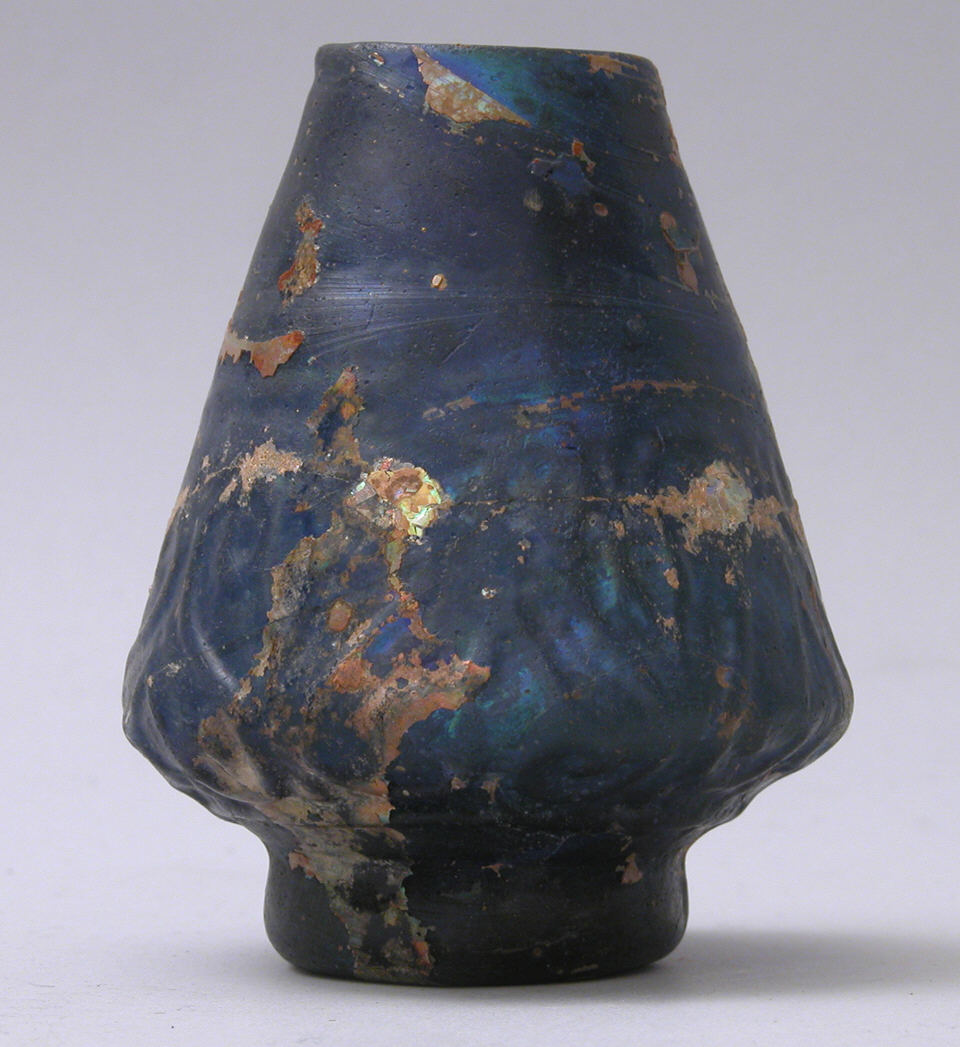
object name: vial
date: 901-1100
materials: glass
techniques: glassblowing, tooling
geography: iran